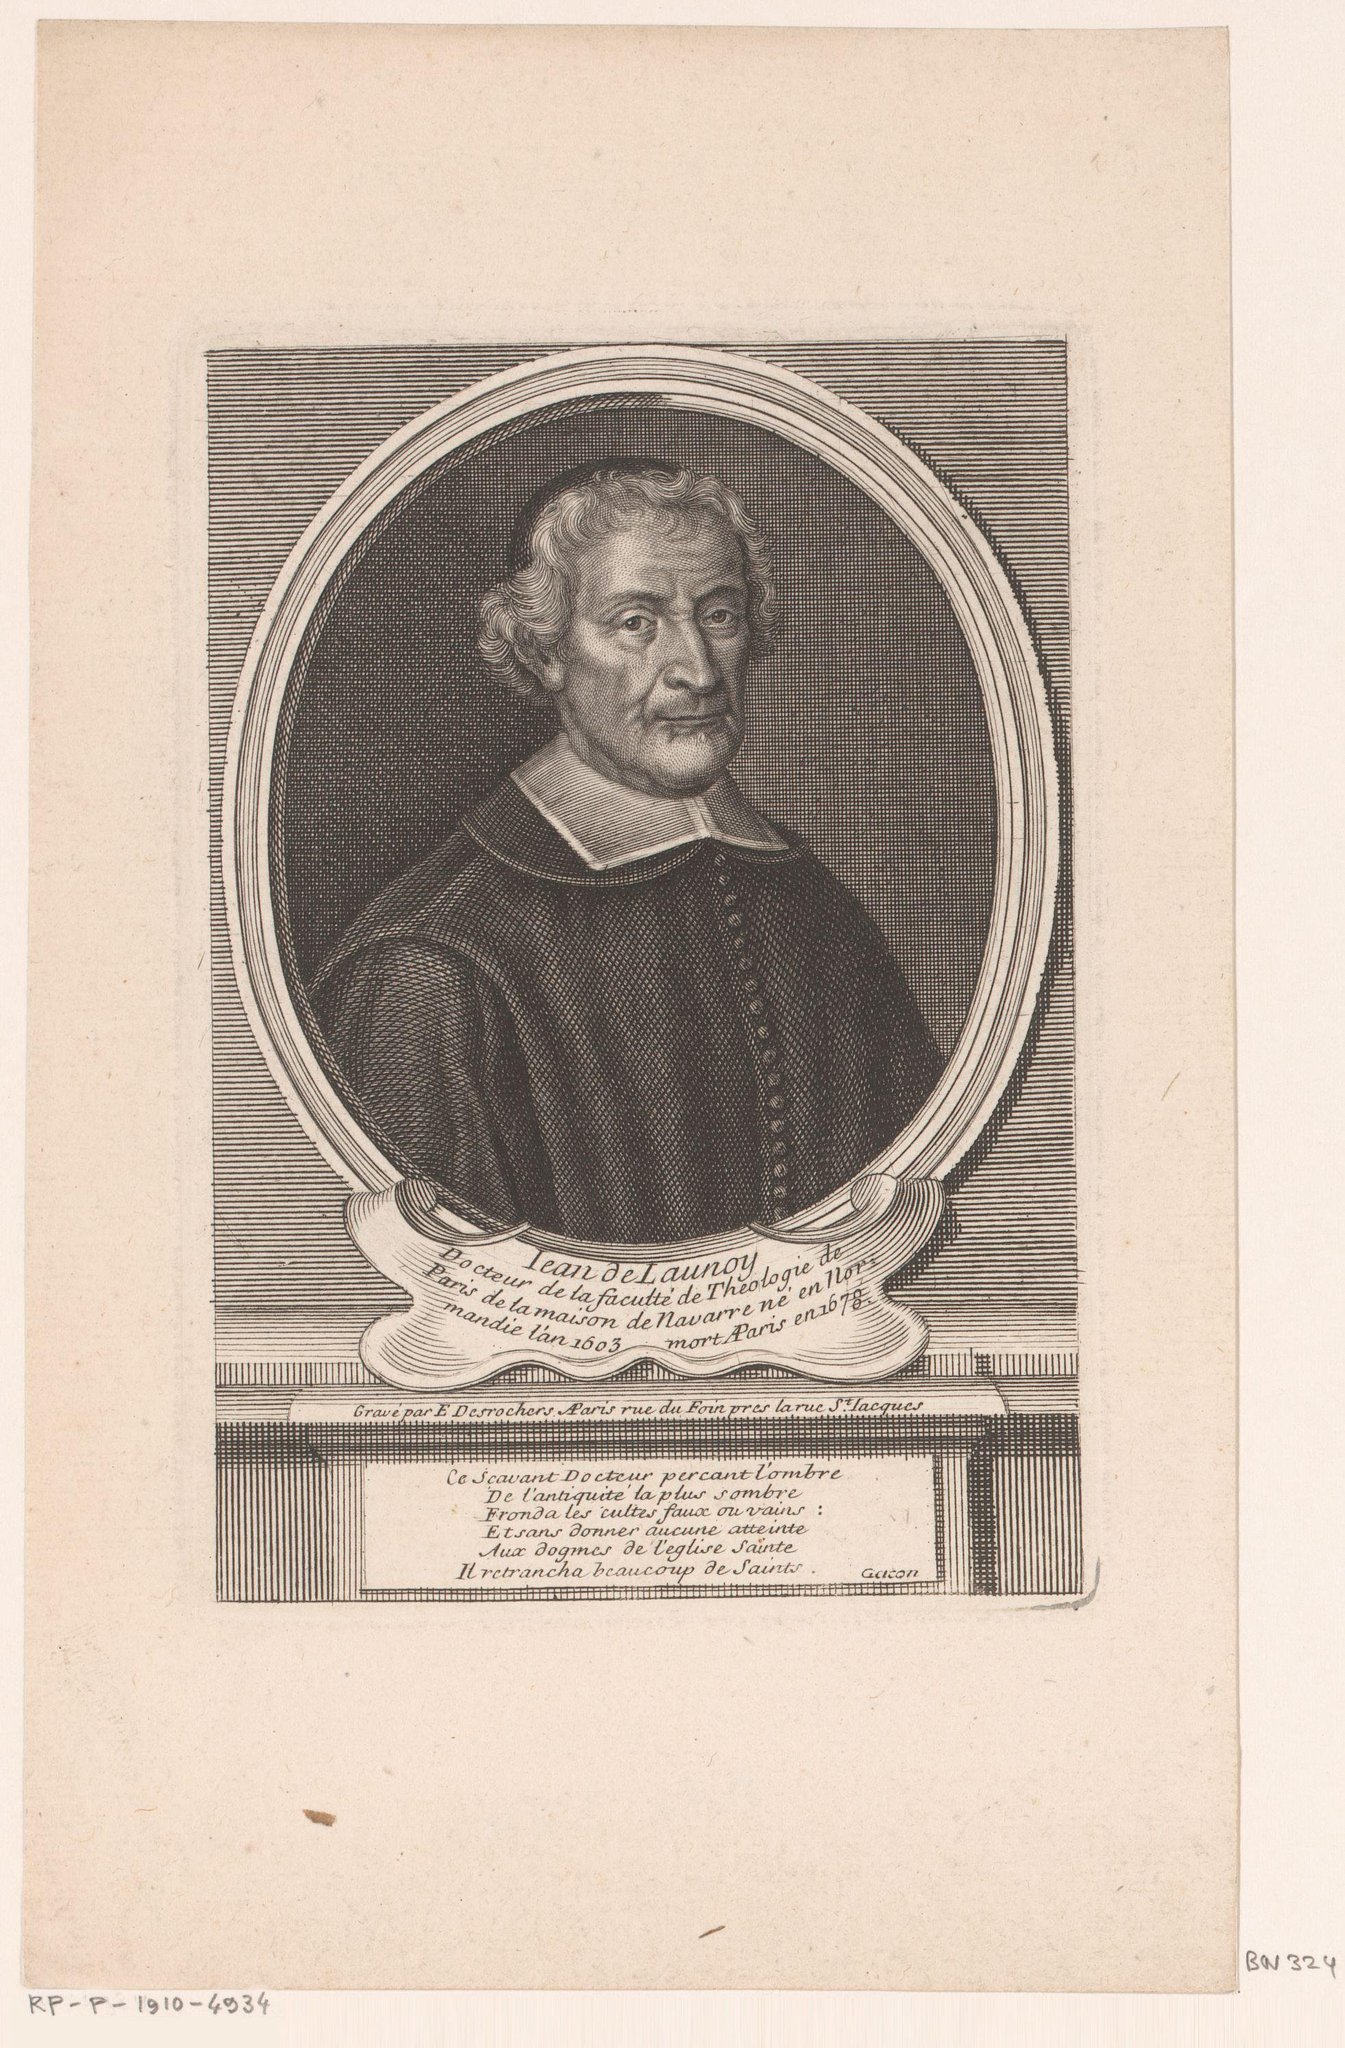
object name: print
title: Recueil de portraits (...)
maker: étienne desrochers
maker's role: print maker, publisher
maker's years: 1668-1741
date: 1726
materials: paper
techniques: engraving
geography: paris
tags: paris, priest, historical persons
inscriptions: collector's mark: Lugt 2228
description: Behoort waarschijnlijk tot een serie portretten, grotendeels door Etienne Desrochers, getiteld: 'Recueil de portraits de personnes qui se sont distinguées tant dans les Armes que dans Belles-Lettres et les Arts, comme aussi la famille royale de France et autres cours étrangères'. De serie werd initieel uitgegeven door Desrochers en aangekondigd in 'Mercure' in mei 1726, p. 985. Echter was Desrochers reeds enkele jaren eerder begonnen met het uitgeven van de serie. Na de dood van Desrochers werd de serie voortgezet door Gilles Edme Petit. Een latere staat werd uitgegeven door Jean François Daumont in Parijs.